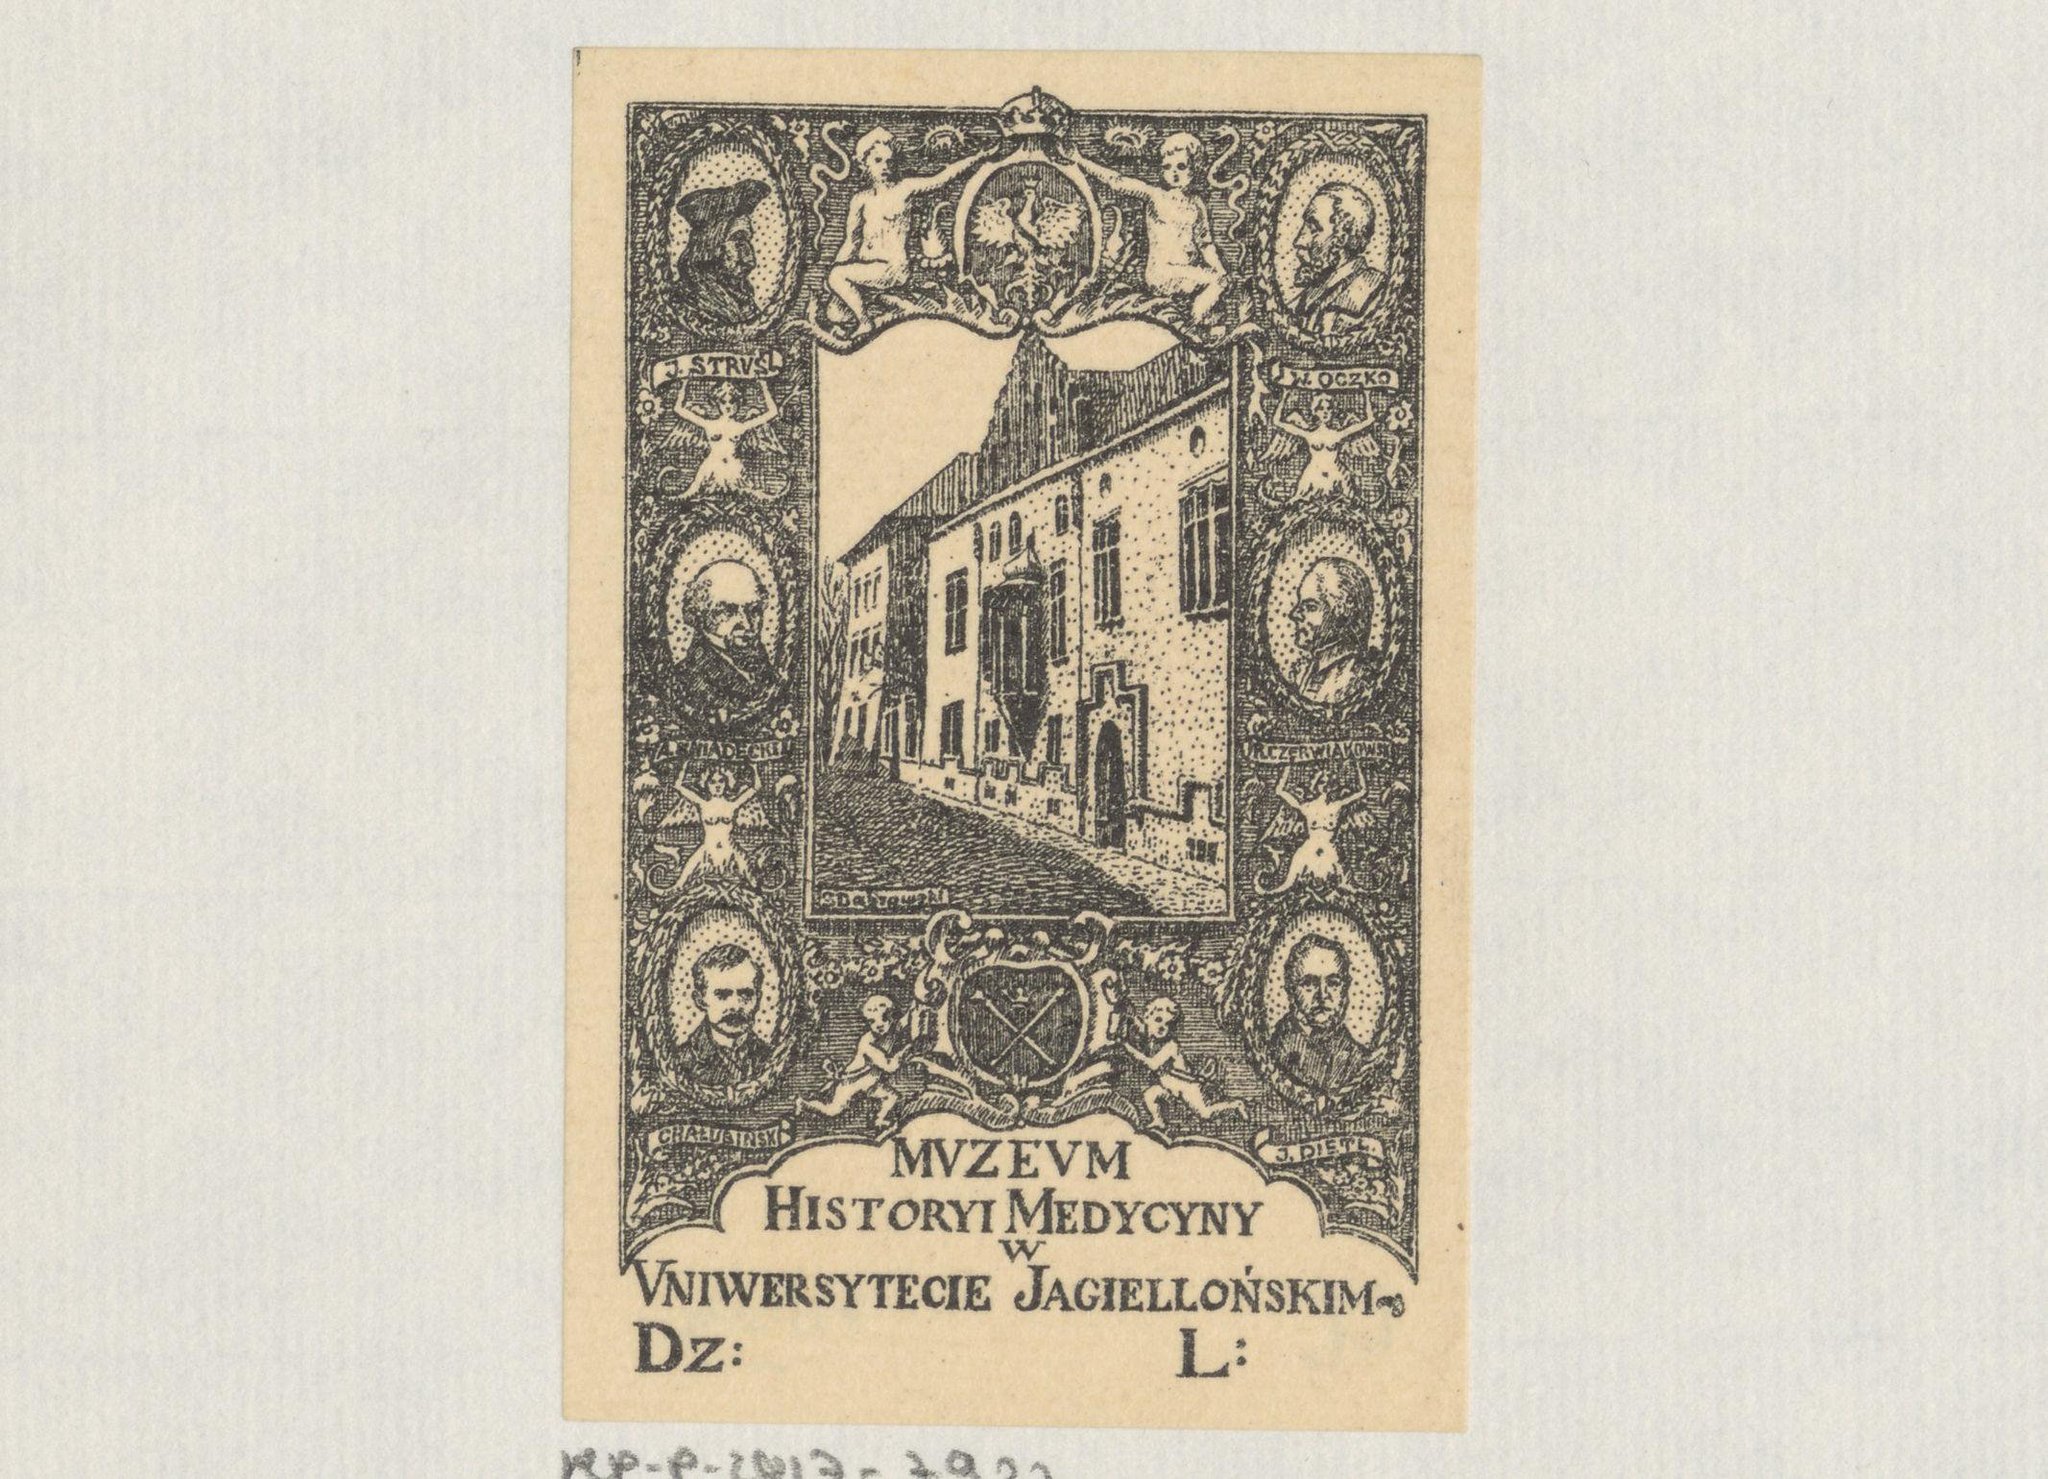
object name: bookplate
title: Muzeum Historyi Medycyny w Universytecie Jagiellonskim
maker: Anonymous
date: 1850-1949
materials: paper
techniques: printing block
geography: poland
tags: historical persons, housing, medicine, medical science